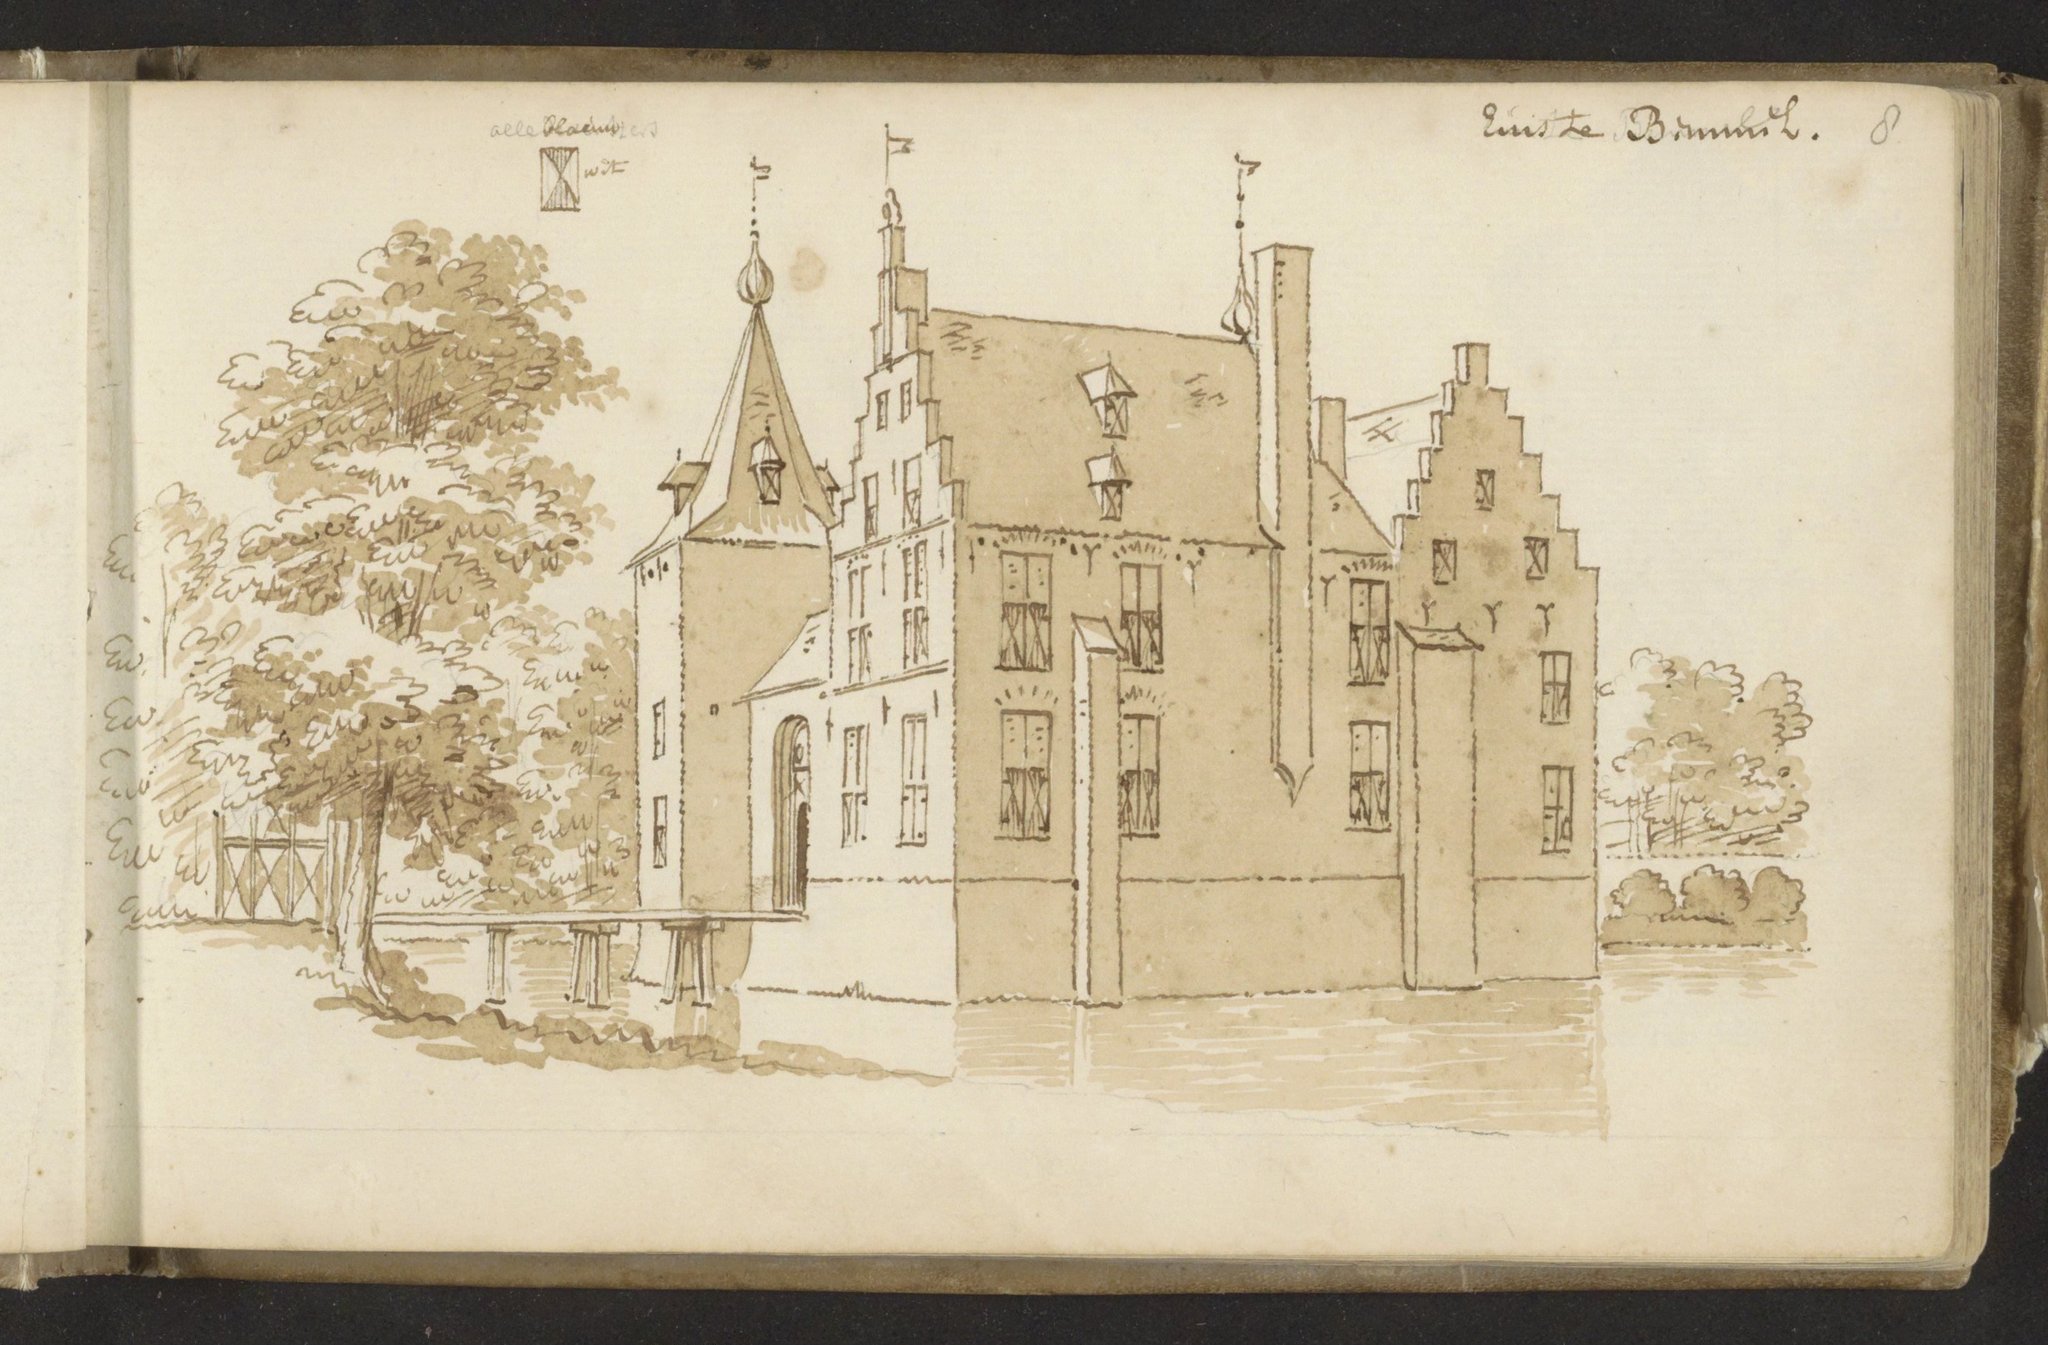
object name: sketchbook leaf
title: Huis te Bemmel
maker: abraham de haen (ii)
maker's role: draughtsman, print maker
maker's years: 1707-1748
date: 1731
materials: ink, paper, pencil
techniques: brush, pen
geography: bemmel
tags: castle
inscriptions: annotation: ‘huis te Bemmel.’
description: Huis te Bemmel gezien vanaf zijkant met links ingang en brug over gracht. Boven kleine schets van luik met notitie kleuraanduiding. Blad 8 recto uit een schetsboek met 69 bladen.